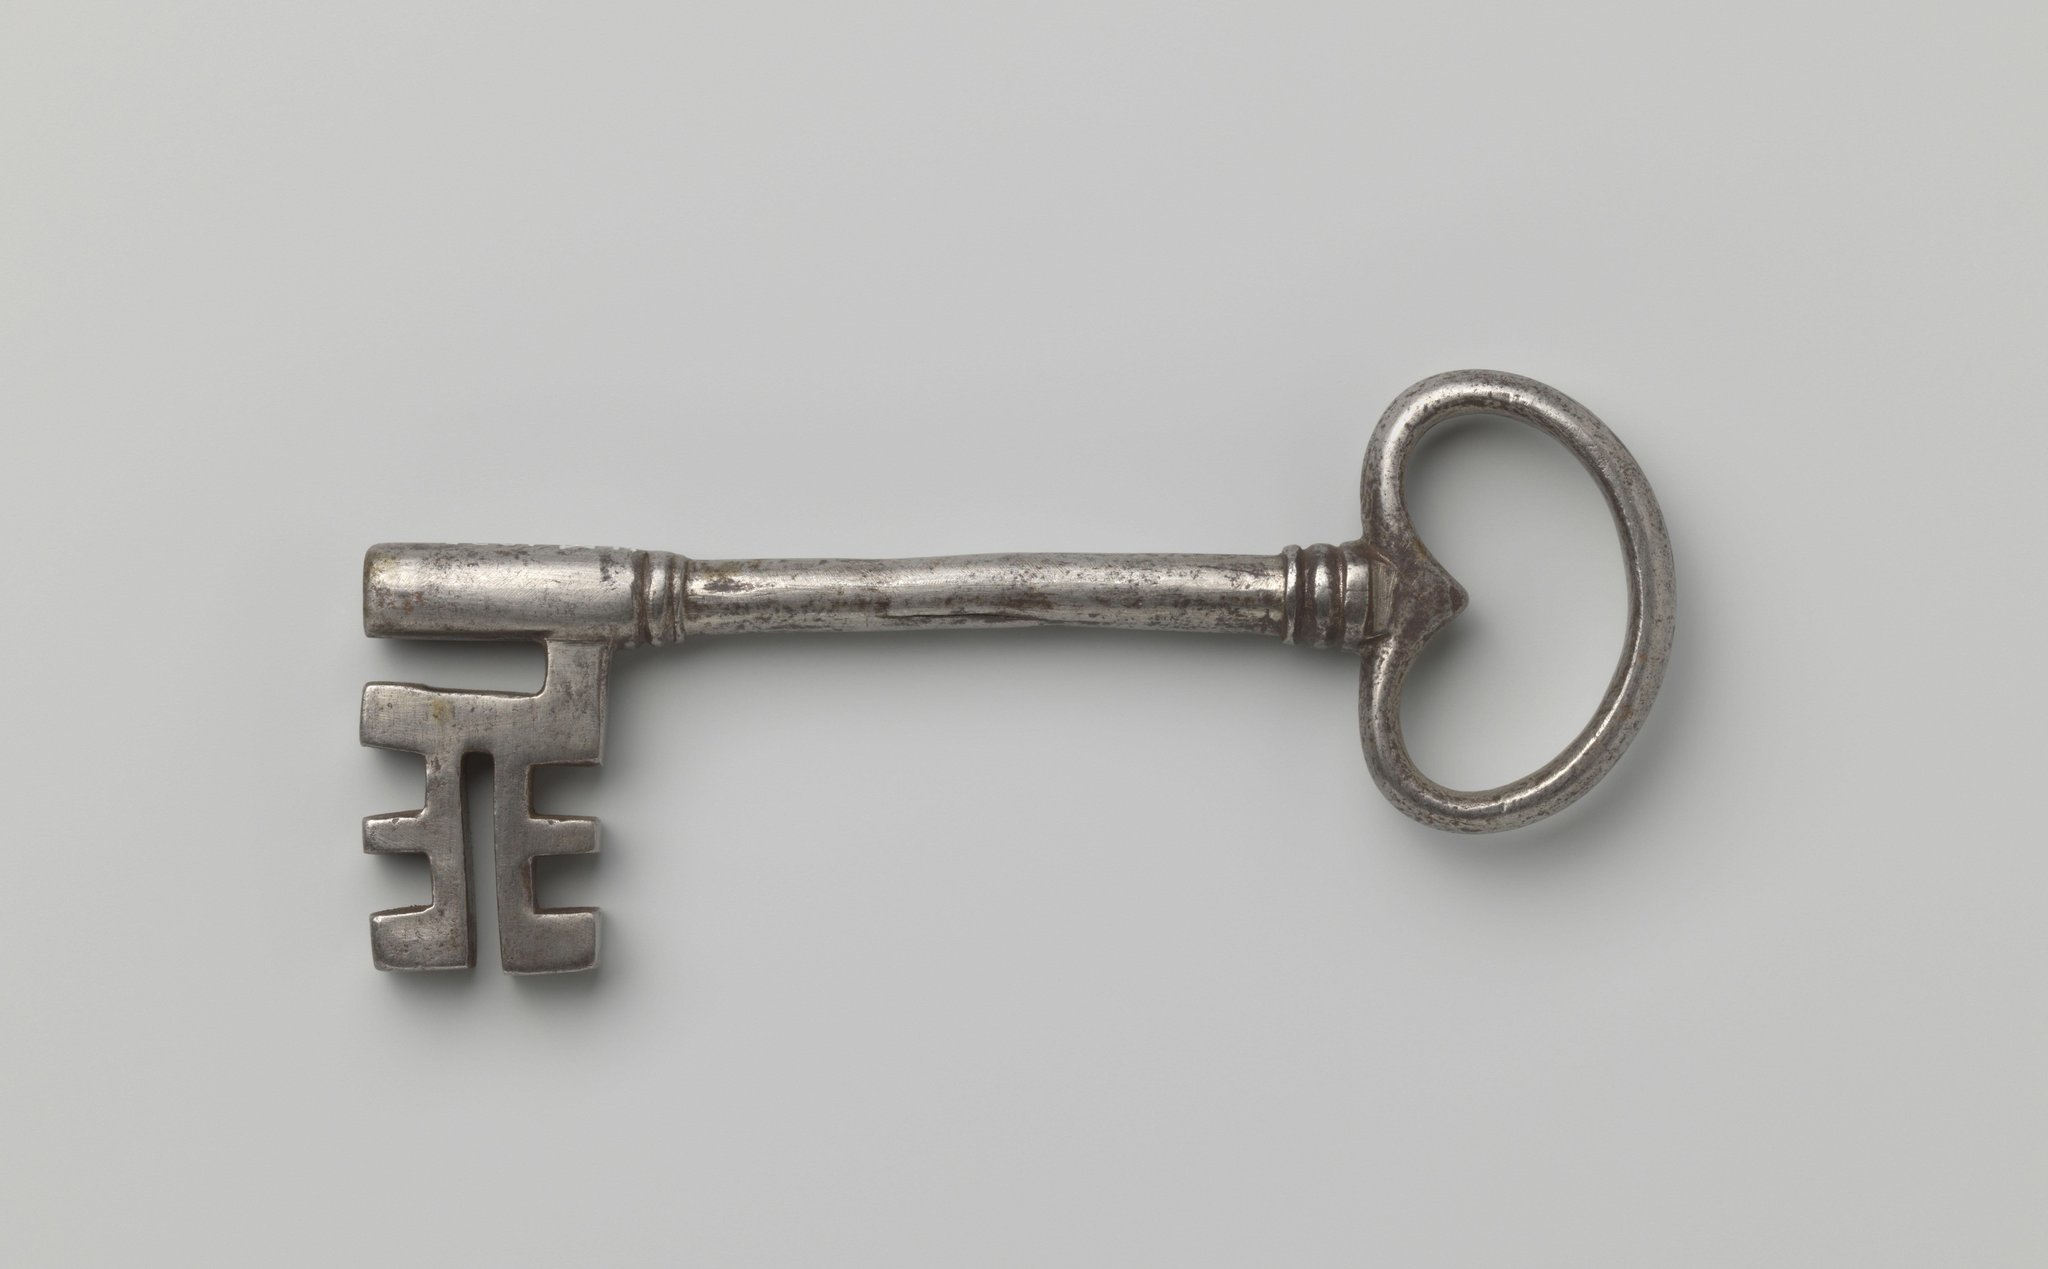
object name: key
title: Sleutel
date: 1499-1599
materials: iron